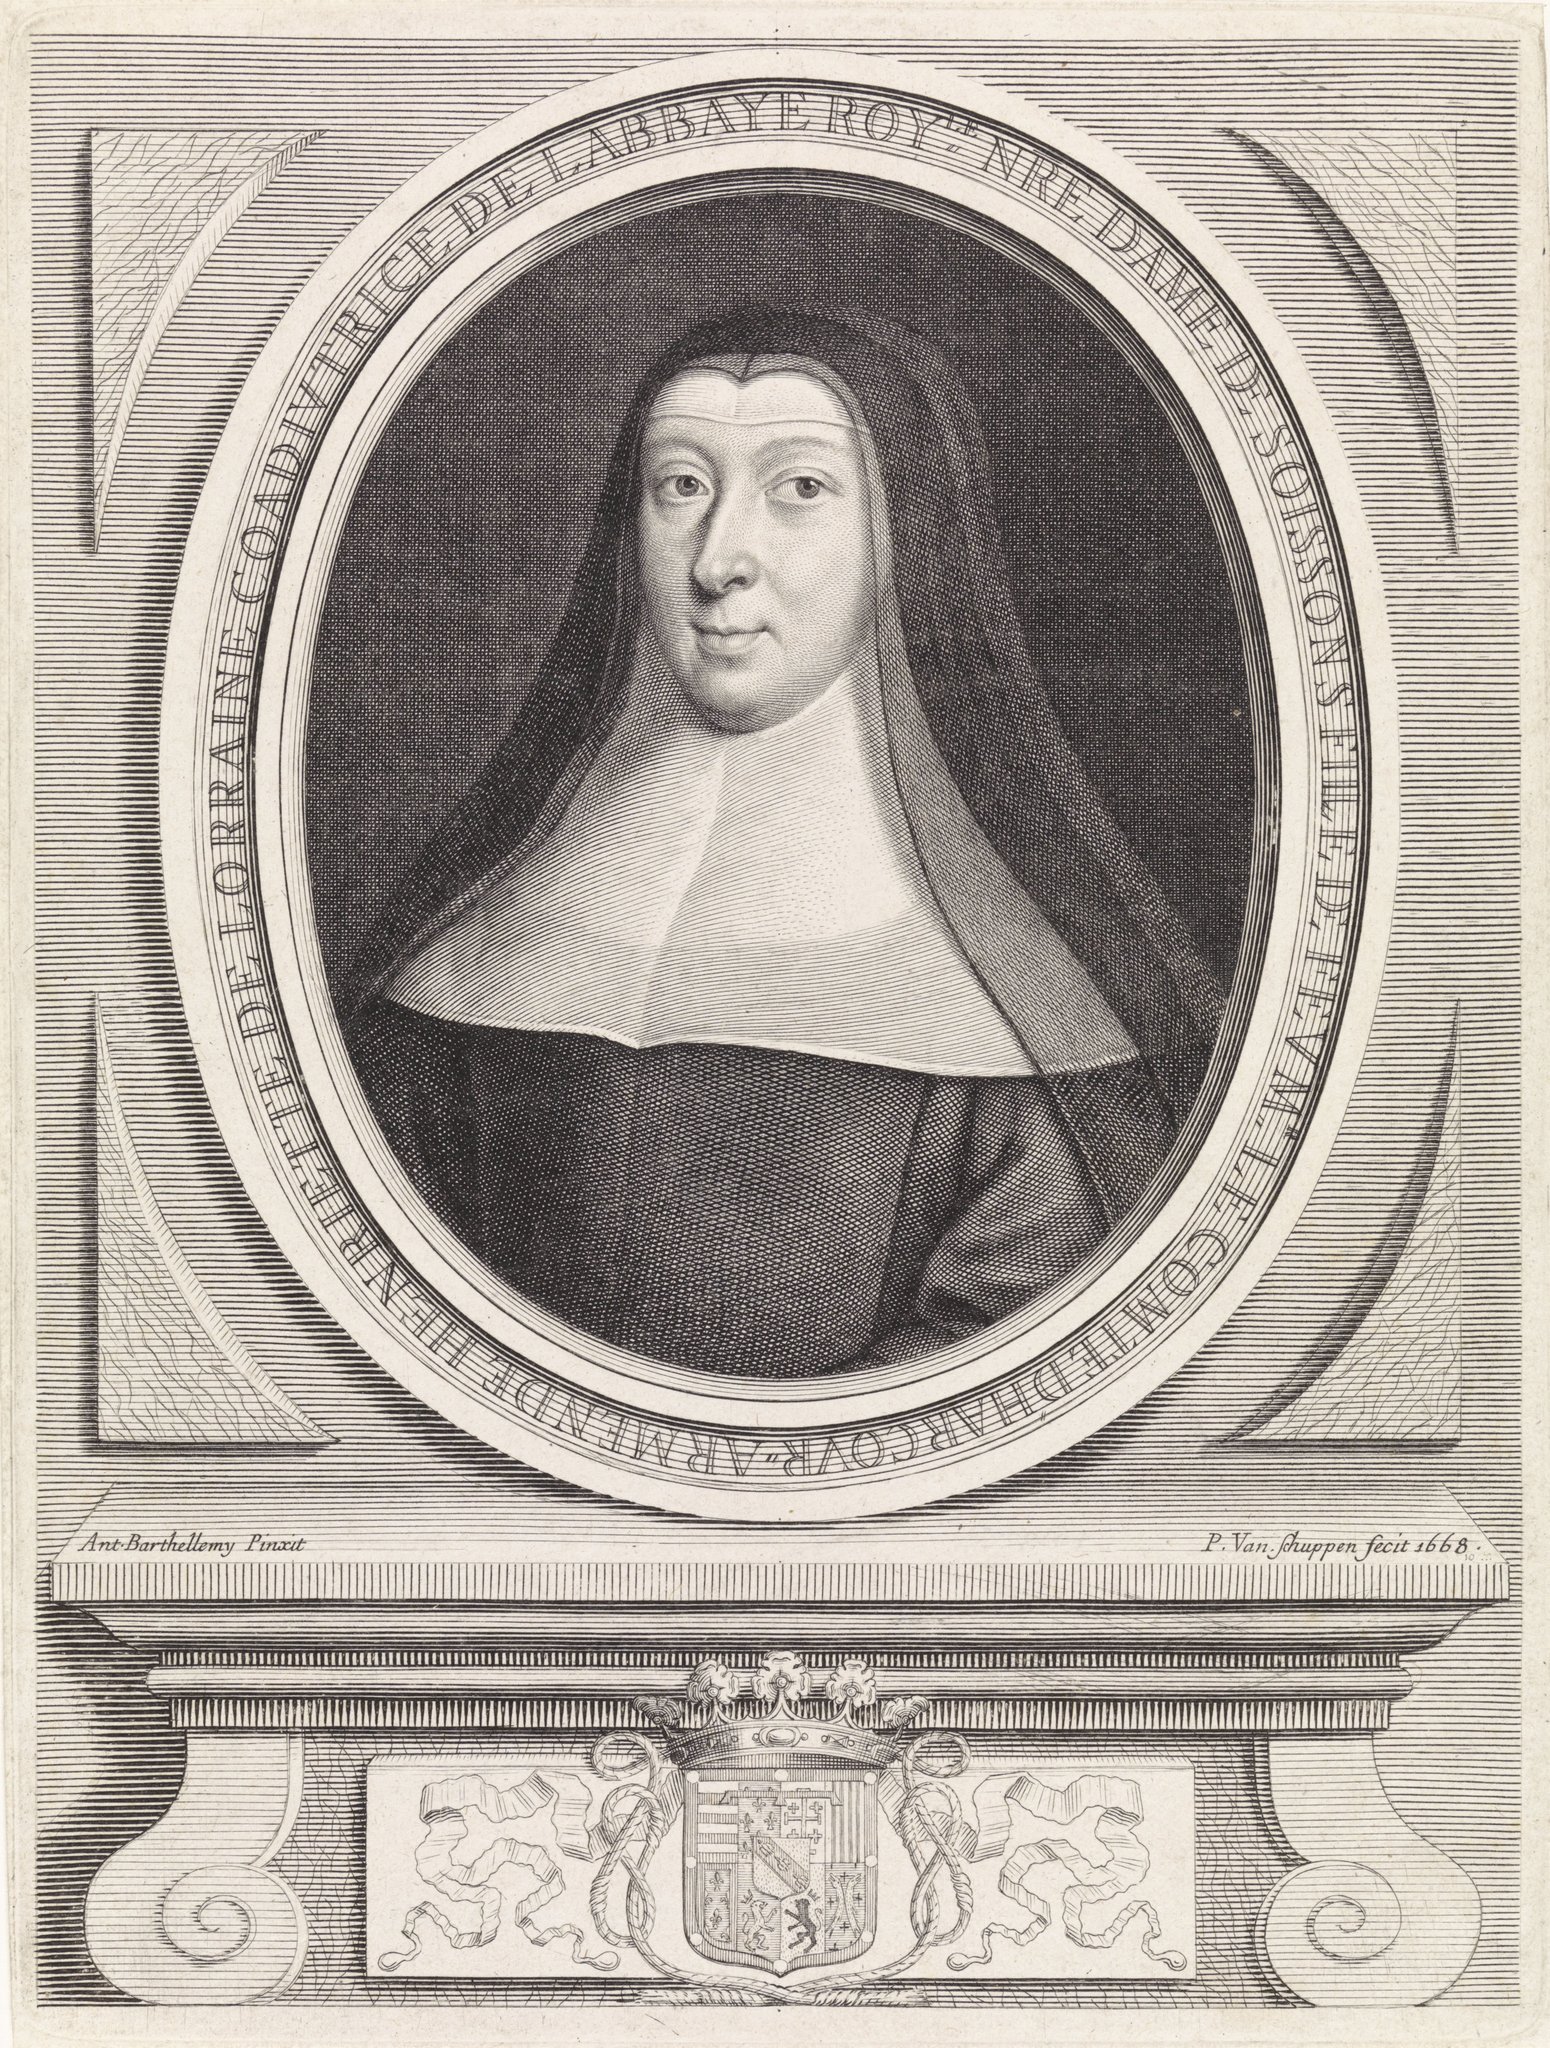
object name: print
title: Portret van Henriëtte van Lotharingen, prinses van Pfalzburg, als non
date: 1610-1668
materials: paper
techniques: engraving, etching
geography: paris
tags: nun(s)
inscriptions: collector's mark: Lugt 2228